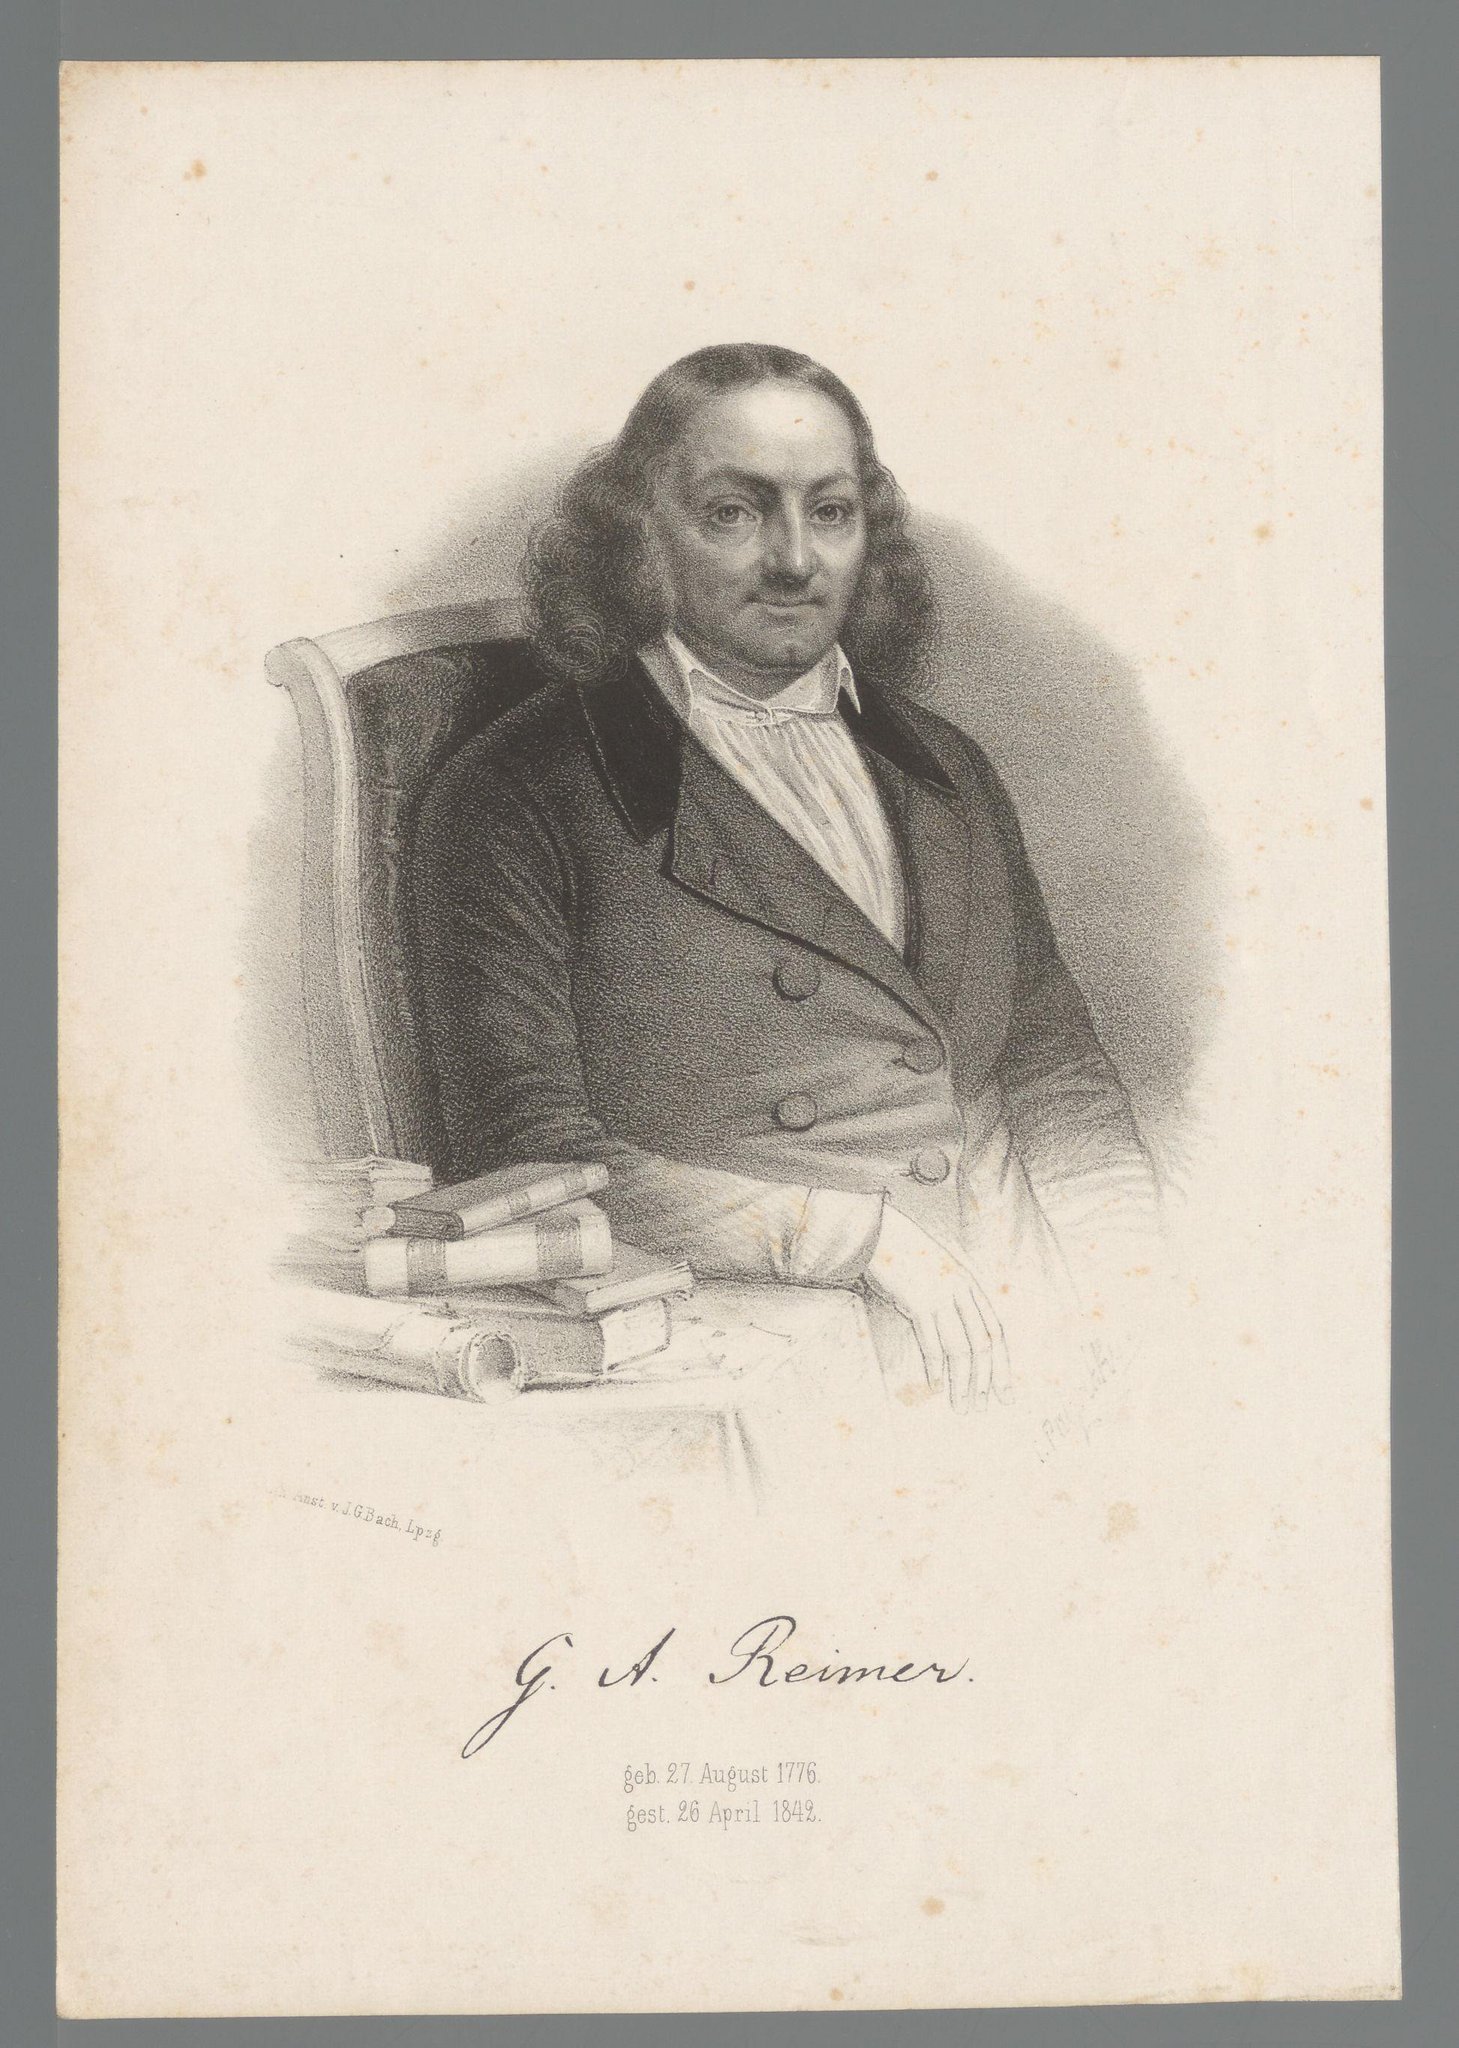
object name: print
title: Portret van Georg Andreas Reimer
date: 1849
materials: paper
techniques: lithograph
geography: leipzig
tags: publisher, adult man, historical persons, book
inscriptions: collector's mark: Lugt 2228